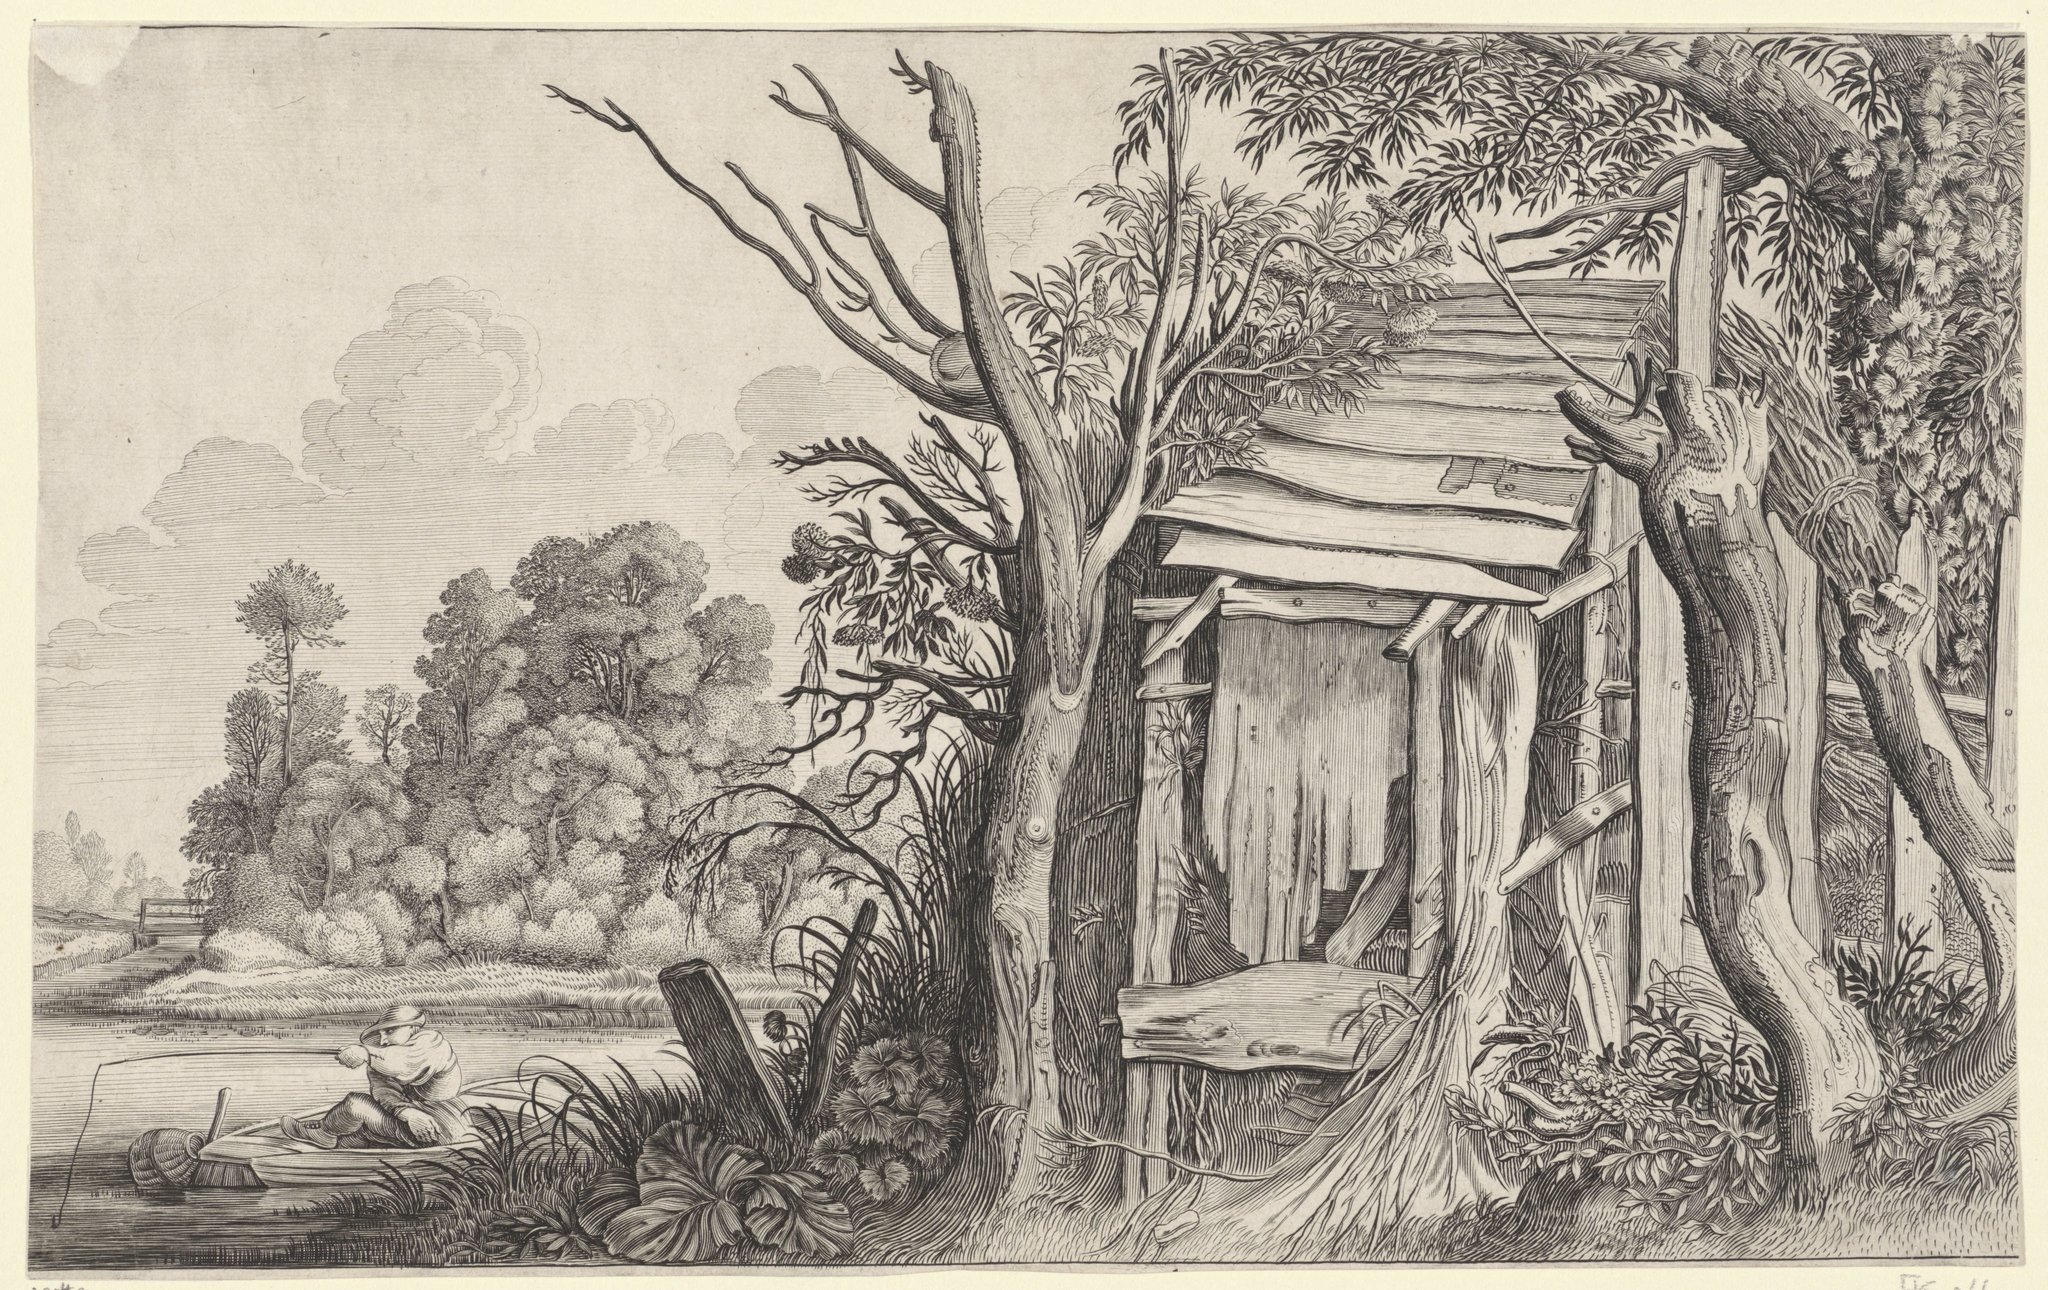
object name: print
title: Landschappen naar Pieter de Molijn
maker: jan van de velde (ii)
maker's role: draughtsman, painter, print maker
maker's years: 1593-1641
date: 1604-1641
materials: paper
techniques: engraving, etching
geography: northern netherlands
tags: trees, shed, hut, cabin, lodge, angling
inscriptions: collector's mark: Lugt 2228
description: De visser is getekend door Buytewech. Tek. in Washington (inv.nr. 1979.76.1) Tent. Cat. Haarlem, The Seventeenth Century, Rutgers, N.Y.